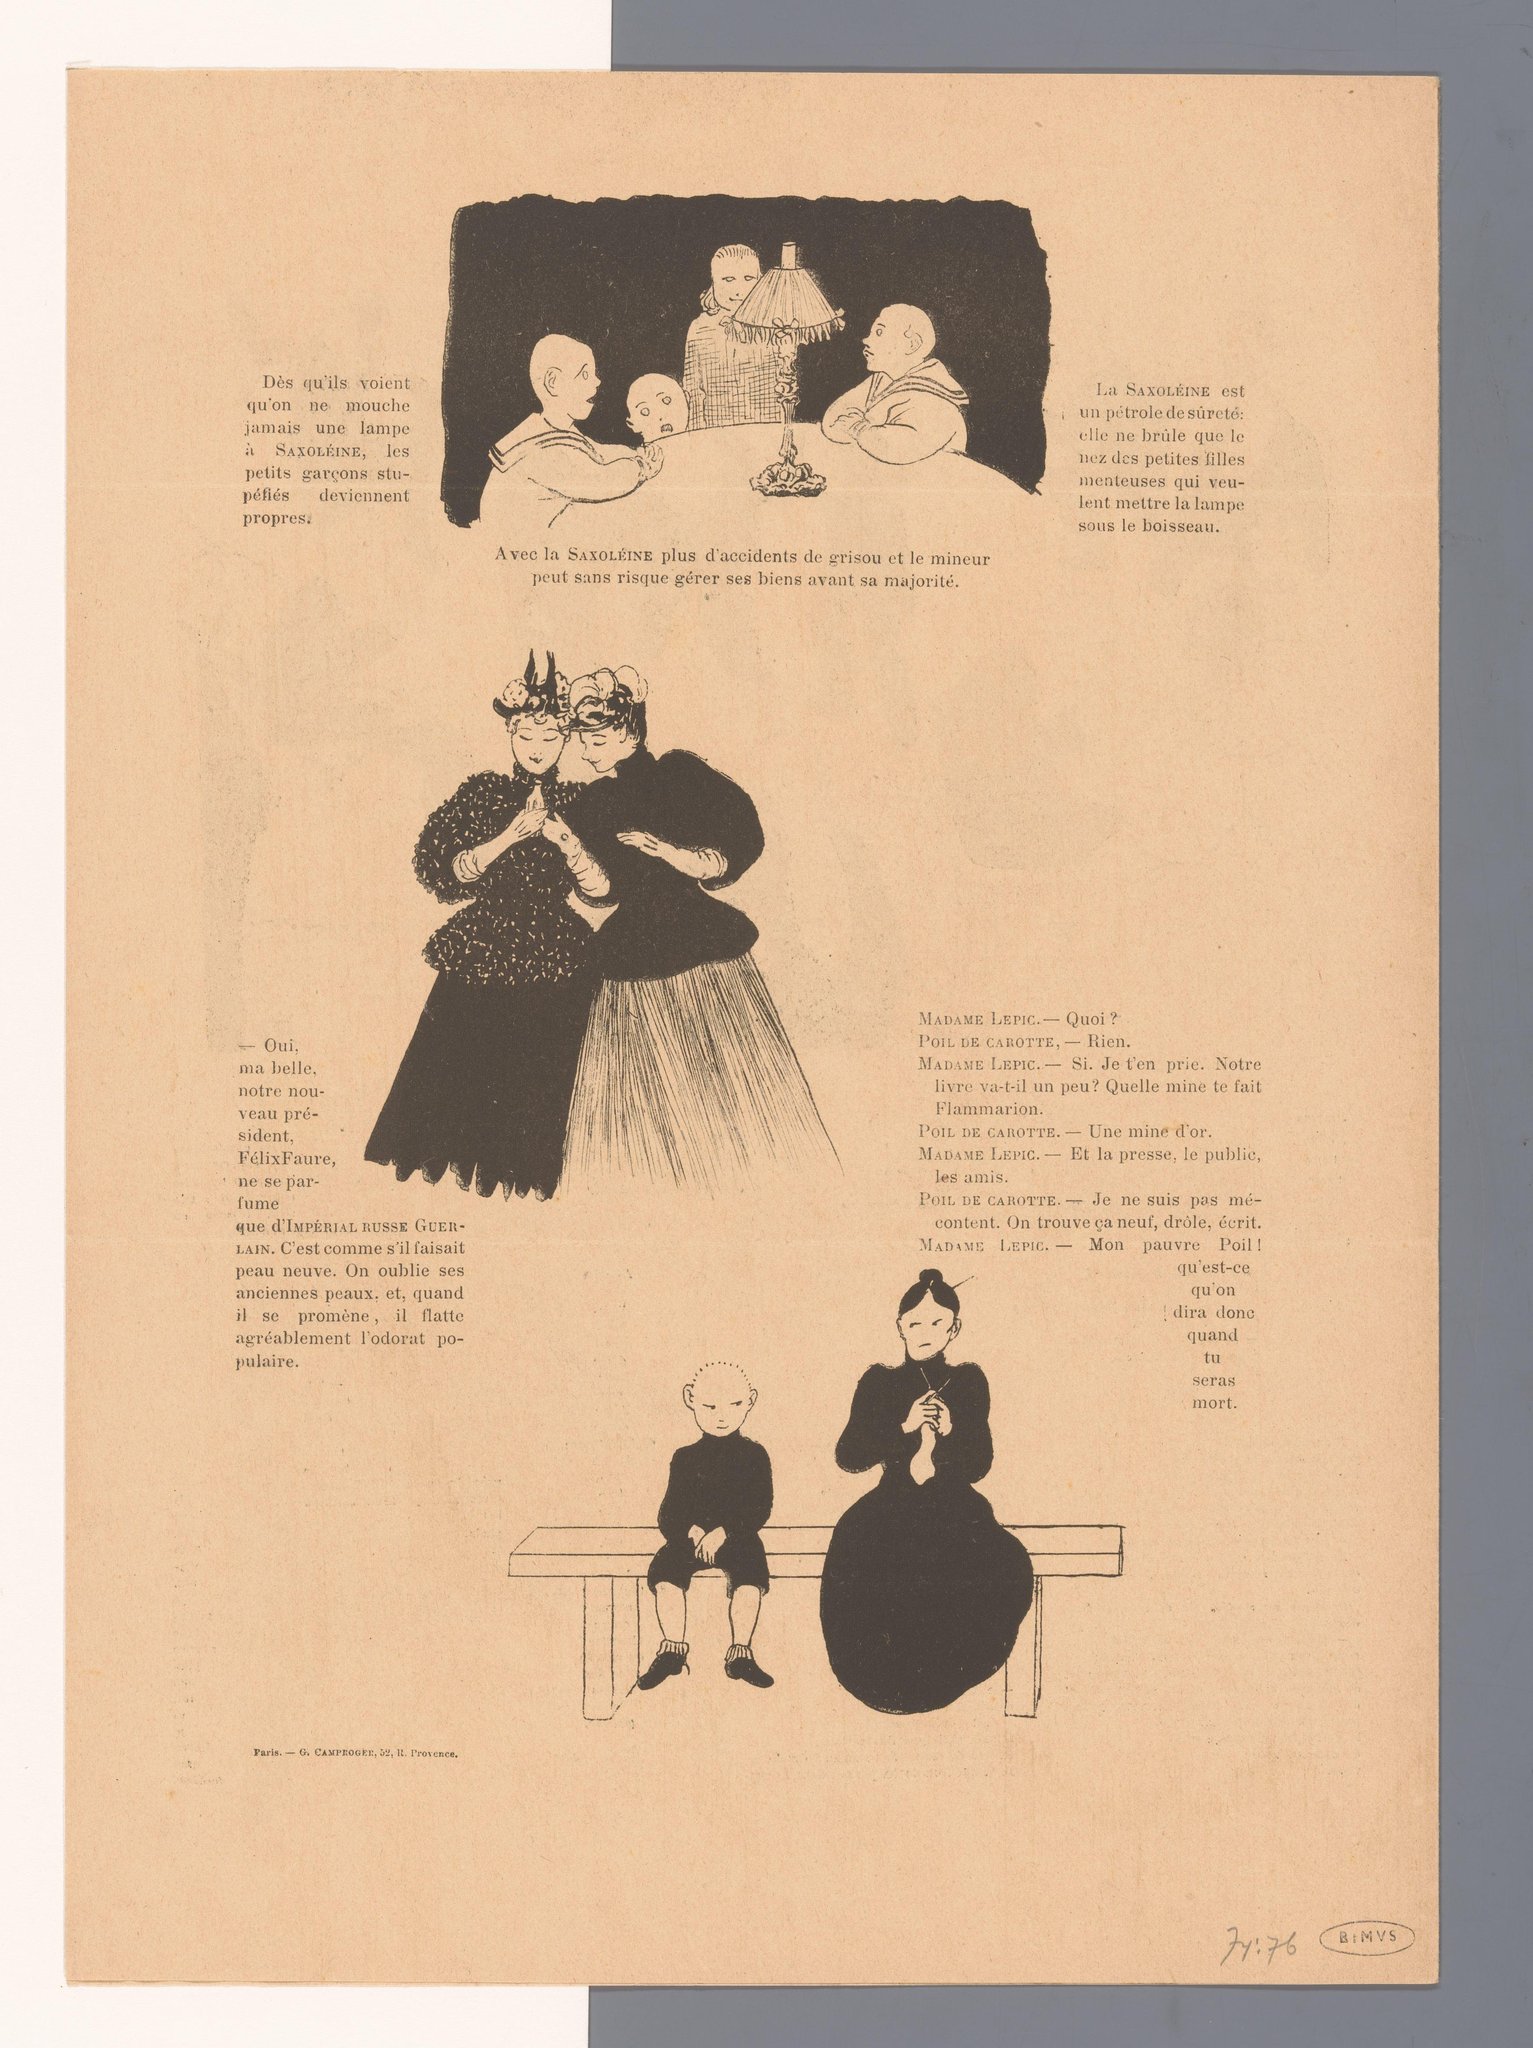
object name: print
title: Groep mensen en twee priesters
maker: félix edouard vallotton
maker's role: print maker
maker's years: 1865-1925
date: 1895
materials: paper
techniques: letterpress printing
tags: priest (roman catholic)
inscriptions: collector's mark: Lugt 2228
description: Op het verso twee dames, kinderen aan een tafel, jongen en breiende dame op een bank.